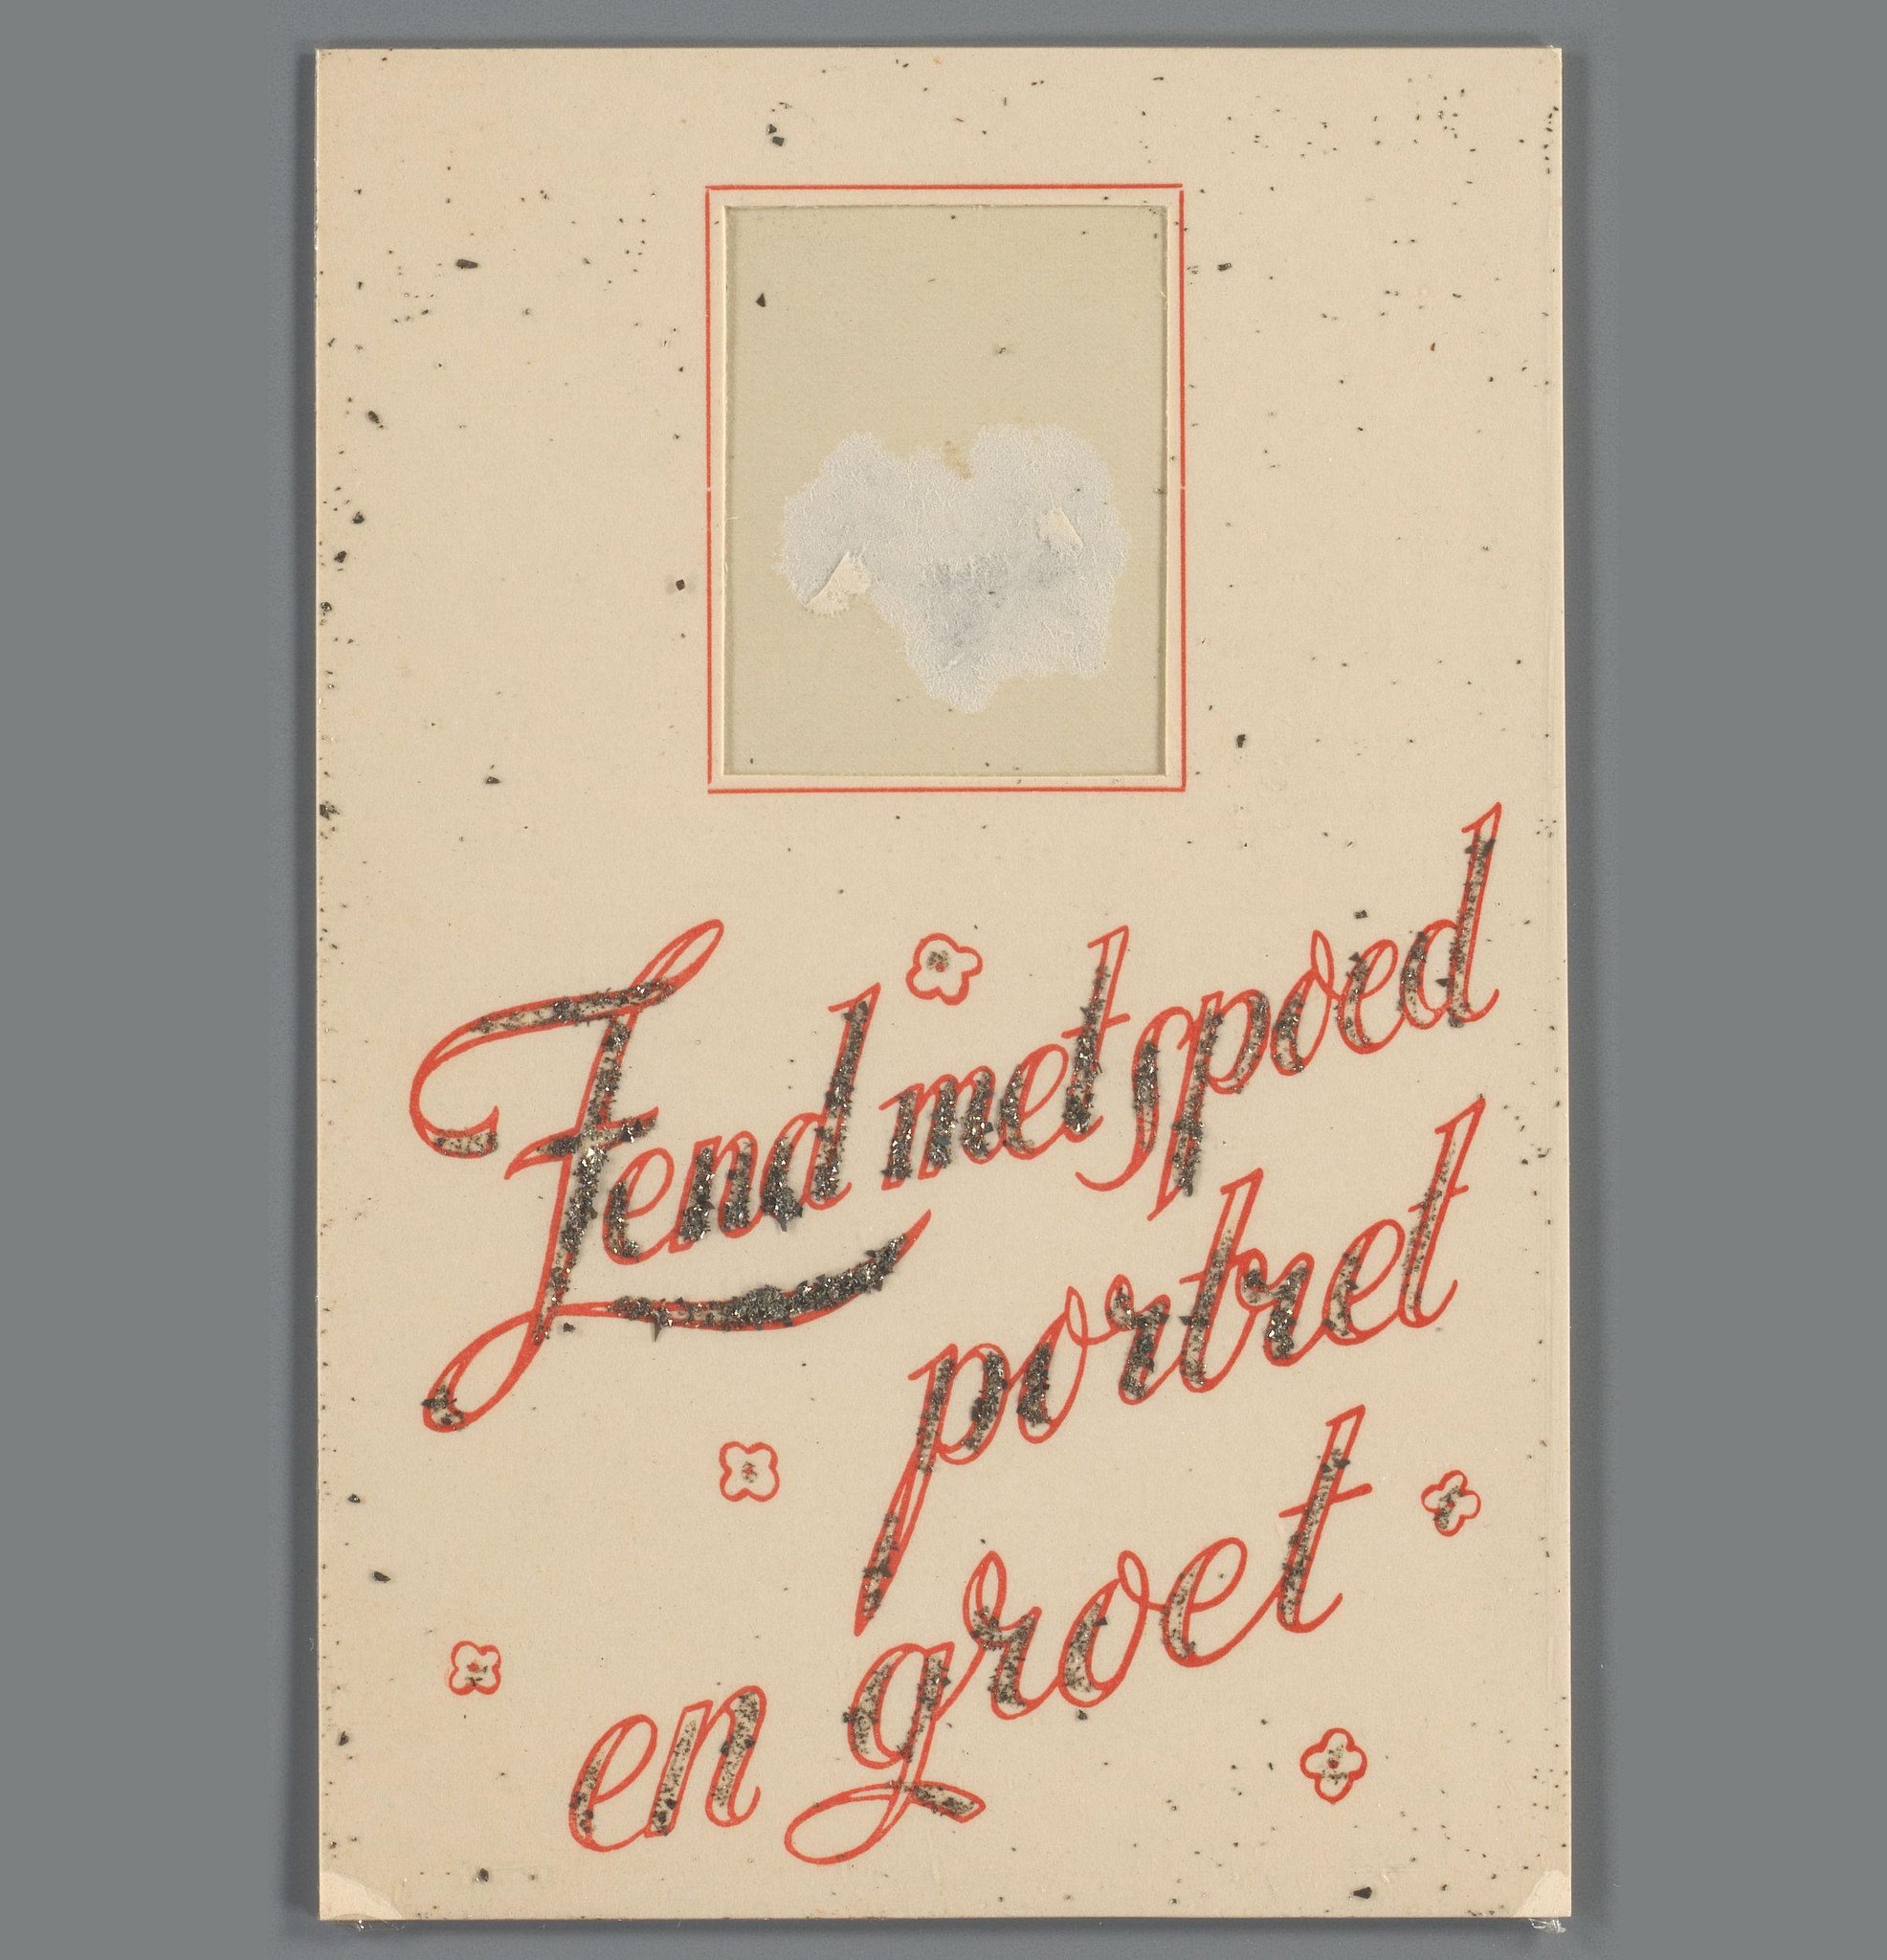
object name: ansichtkaart, prentbriefkaart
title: Zend met spoed portret en groet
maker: Anonymous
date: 1950-1980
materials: cardboard, glitter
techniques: letterpress printing